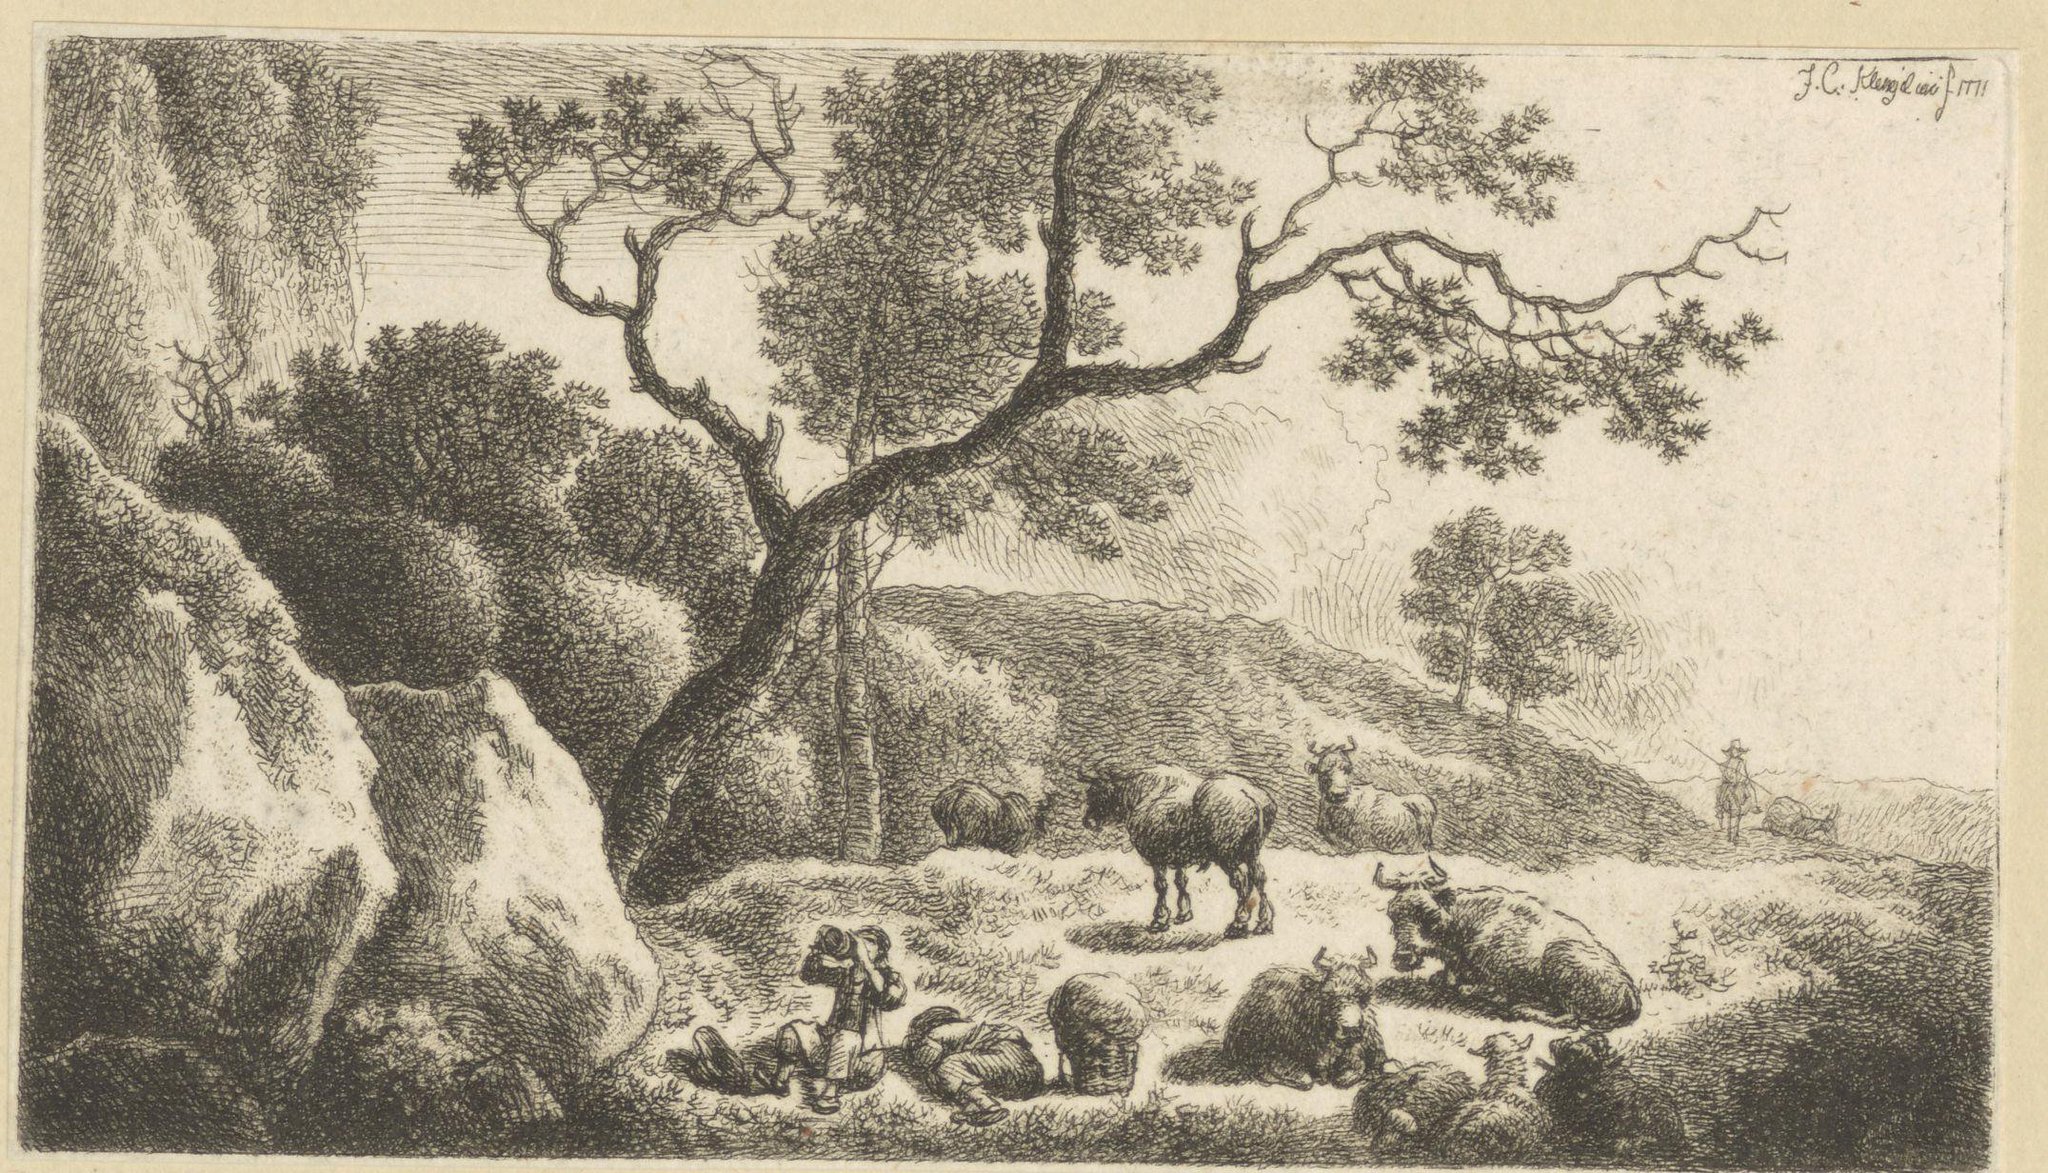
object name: print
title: Landschap met rustende herders en kudde runderen en schapen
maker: johann christian klengel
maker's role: print maker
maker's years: 1751-1824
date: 1771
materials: paper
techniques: etching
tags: herding, herdsman, herdswoman, shepherd, shepherdess, cowherd, etc., cattle, (traveller) resting in the open air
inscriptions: collector's mark: Lugt 240